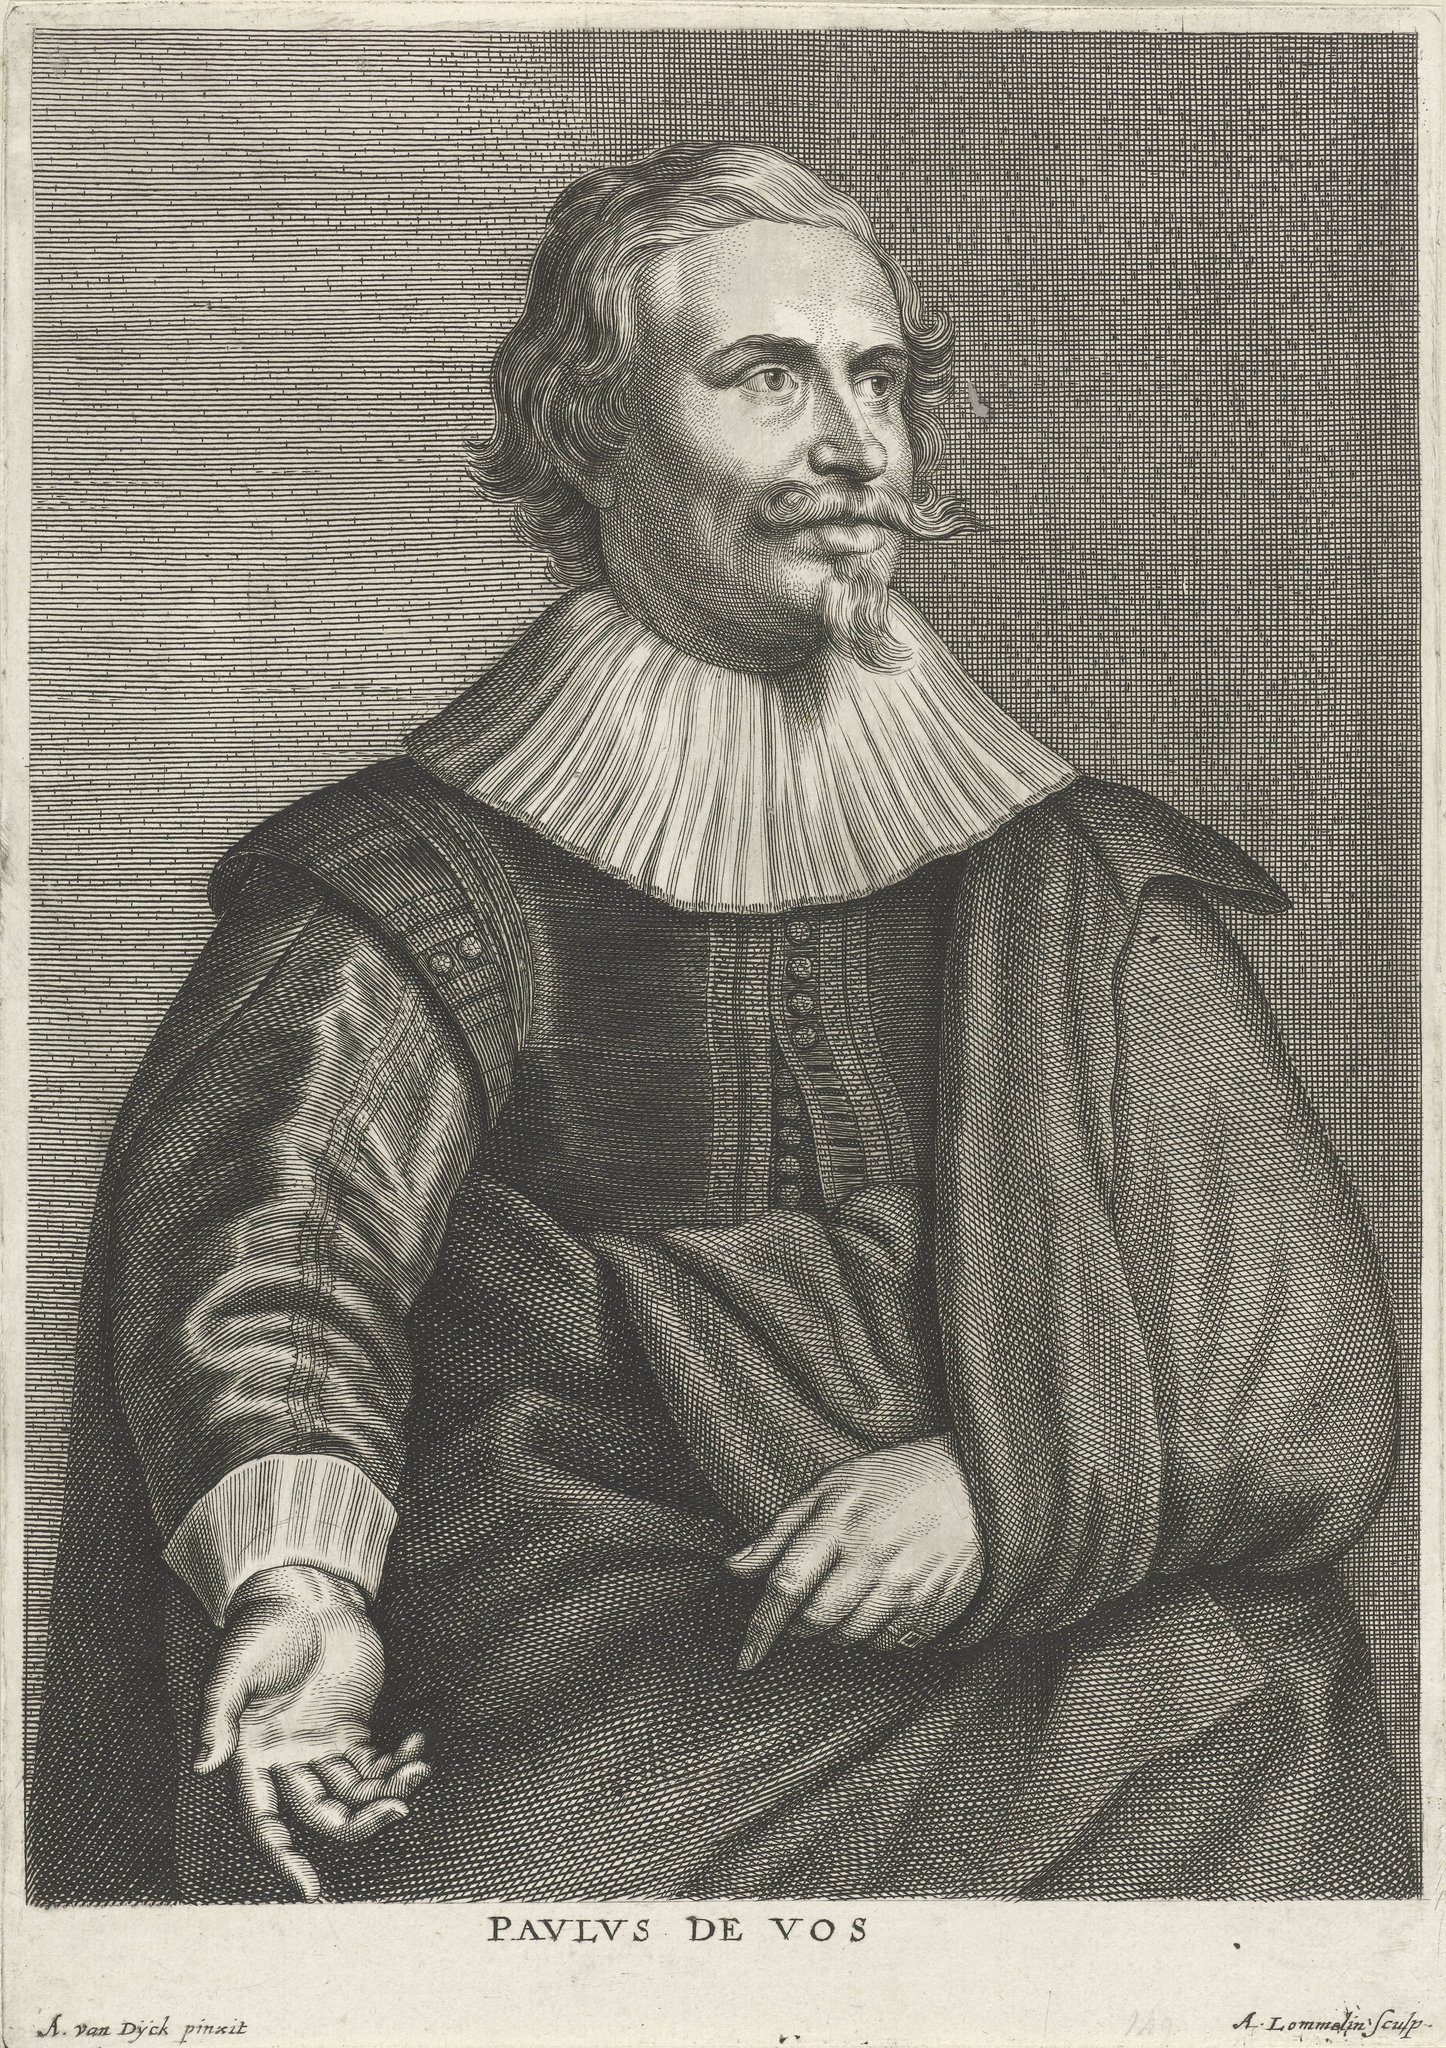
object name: print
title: Portret van Paul de Vos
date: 1630-1677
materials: paper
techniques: engraving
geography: antwerp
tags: antwerp, draughtsman, paul de vos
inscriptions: collector's mark: Lugt 240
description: Portret van Paul de Vos, schilder te Antwerpen.